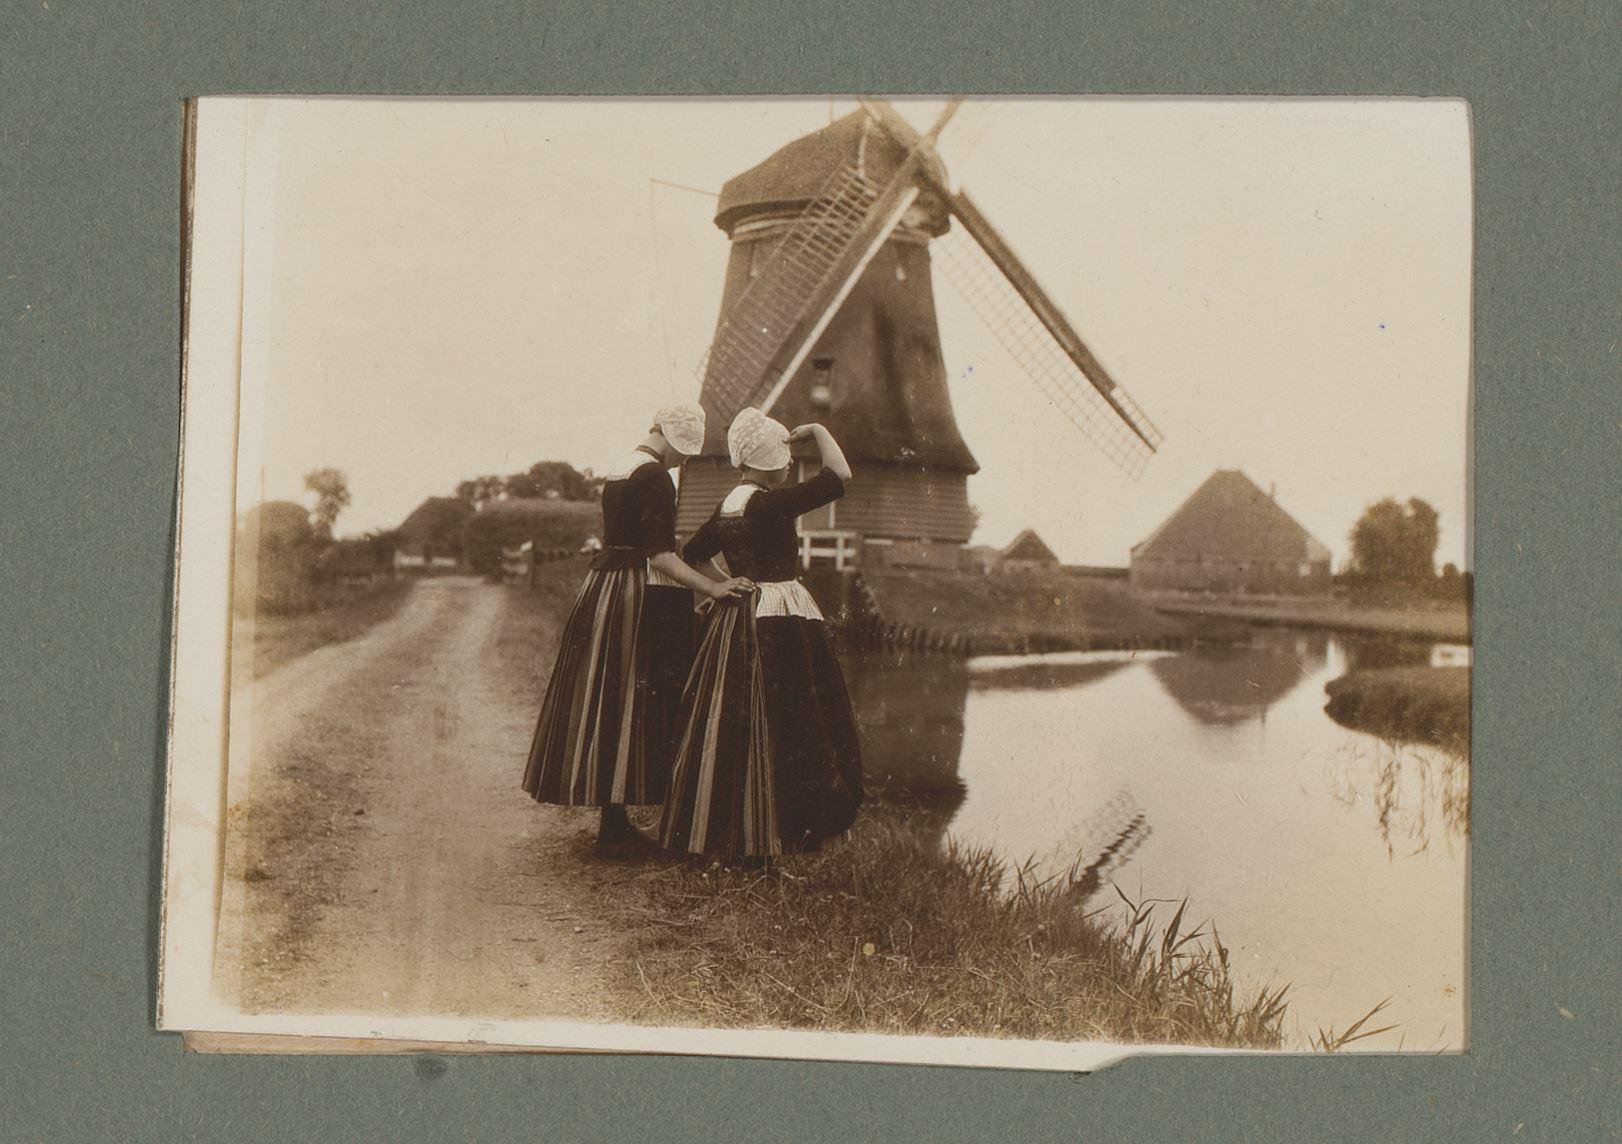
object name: album leaf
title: Twee vrouwen in klederdracht, kijkend over een water bij een molen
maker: george hidderley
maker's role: fotograaf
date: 1920-1940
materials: photographic support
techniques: daylight paper print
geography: netherlands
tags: historical persons - bb - woman, folk costume, regional costume, windmill